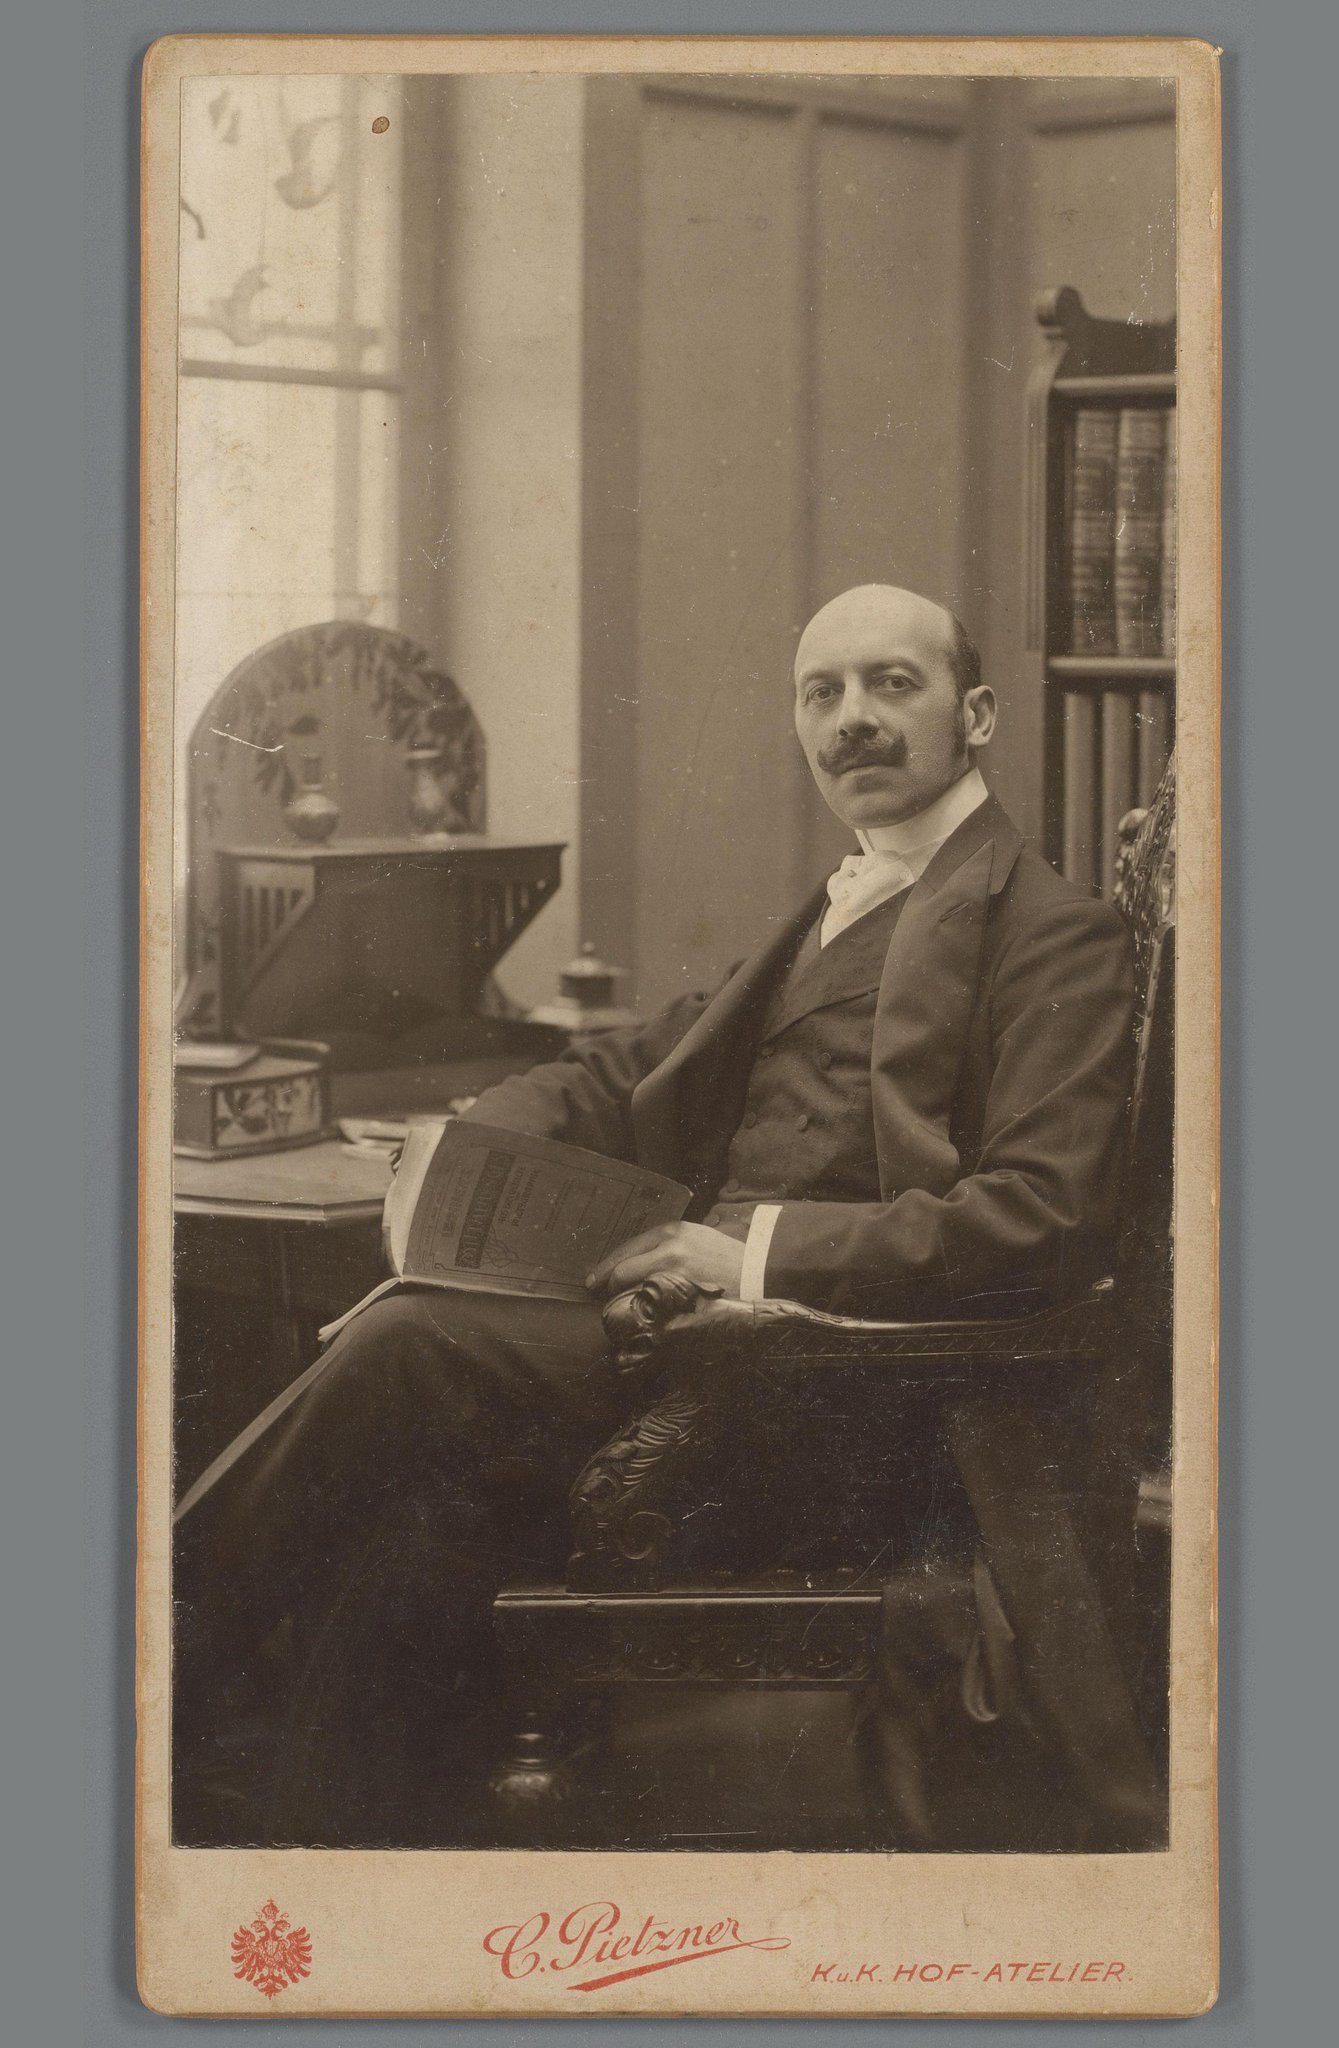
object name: cabinet photograph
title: Portret van een onbekende man in zijn werkkamer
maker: carl pietzner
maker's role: fotograaf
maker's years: 1853-1927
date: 1900-1920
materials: cardboard, photographic support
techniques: gelatin silver print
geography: vienna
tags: moustache, adult man, historical persons, book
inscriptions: inscription: ‘52402/ II’, inscription: ‘K. und K. HOF-u./ KAMMER- PHOTOGRAPH/ C. PIETZNER/ WIEN/ VI. Mariahilferstrasse 3./ TELEPHON No 5063./ WIEN/ TEPLITZ/ CARLSBAD/ BRÜNN/ TROPPAU/ AUSSIG A/E/ BRÜX/ EGER/ OLMÜTZ/ MÄHR. OSTRAU/ KÜNSTLERISCHE AUSFÜH-/ RUNG IN PHOTOGRAPHEN,/ ALLER ARTEN MALEREIEN/ UND COMPOSITIONEN./ PLATTEN No./ ALLERHÖCHSTE AUSZEICHNUNGEN, STAATSPREISE,/ GRAND PRIX u. COLD. MEDAILLEN: LONDON, PARIS, WIEN, ETC. ETC./ DIE PLATTEN BLEIBEN AUFBEWAHRT.’